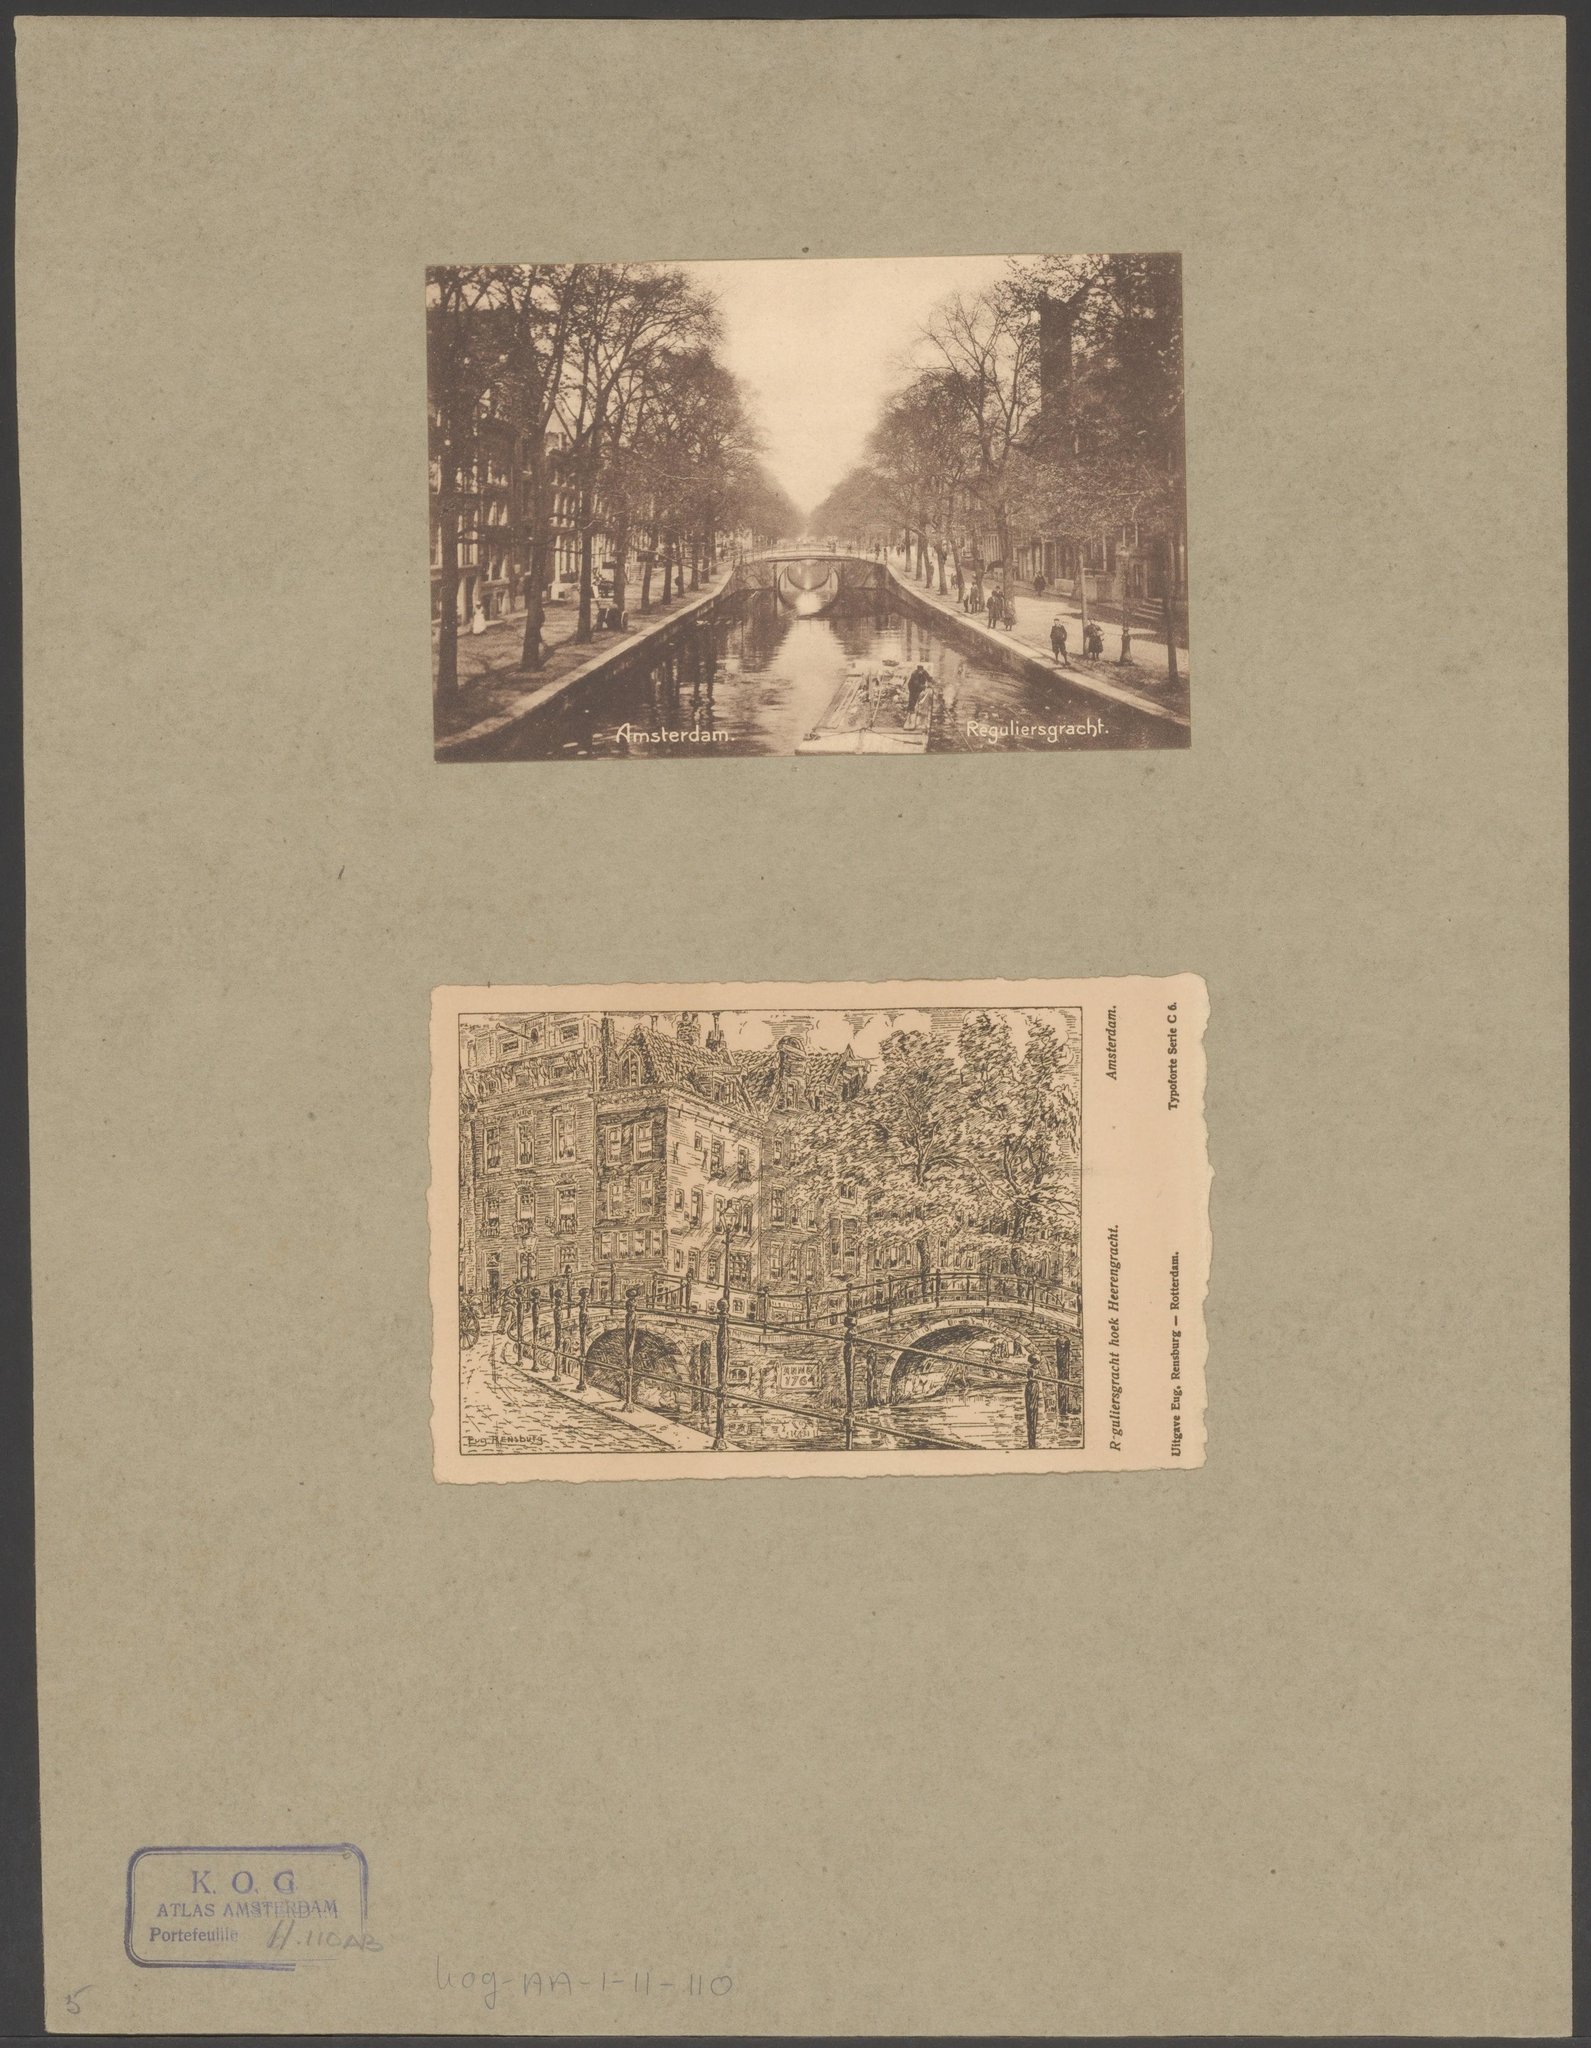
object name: photomechanical print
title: Gezichten op de Reguliersgracht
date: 1875-1930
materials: cardboard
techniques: photograph, line block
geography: rotterdam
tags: city-view in general; 'veduta', canal, the usual house or row of houses, bridge in city across river, canal, etc.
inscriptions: collector's mark: ‘11.110AB’ Lugt 1641b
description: Onderwerpsrubriek binnen de Atlas Amsterdam: Raadhuisstraat, Raamgracht, Raamplein, Rapenburgerstraat, Reguliersgracht, Reguliersbreestraat.